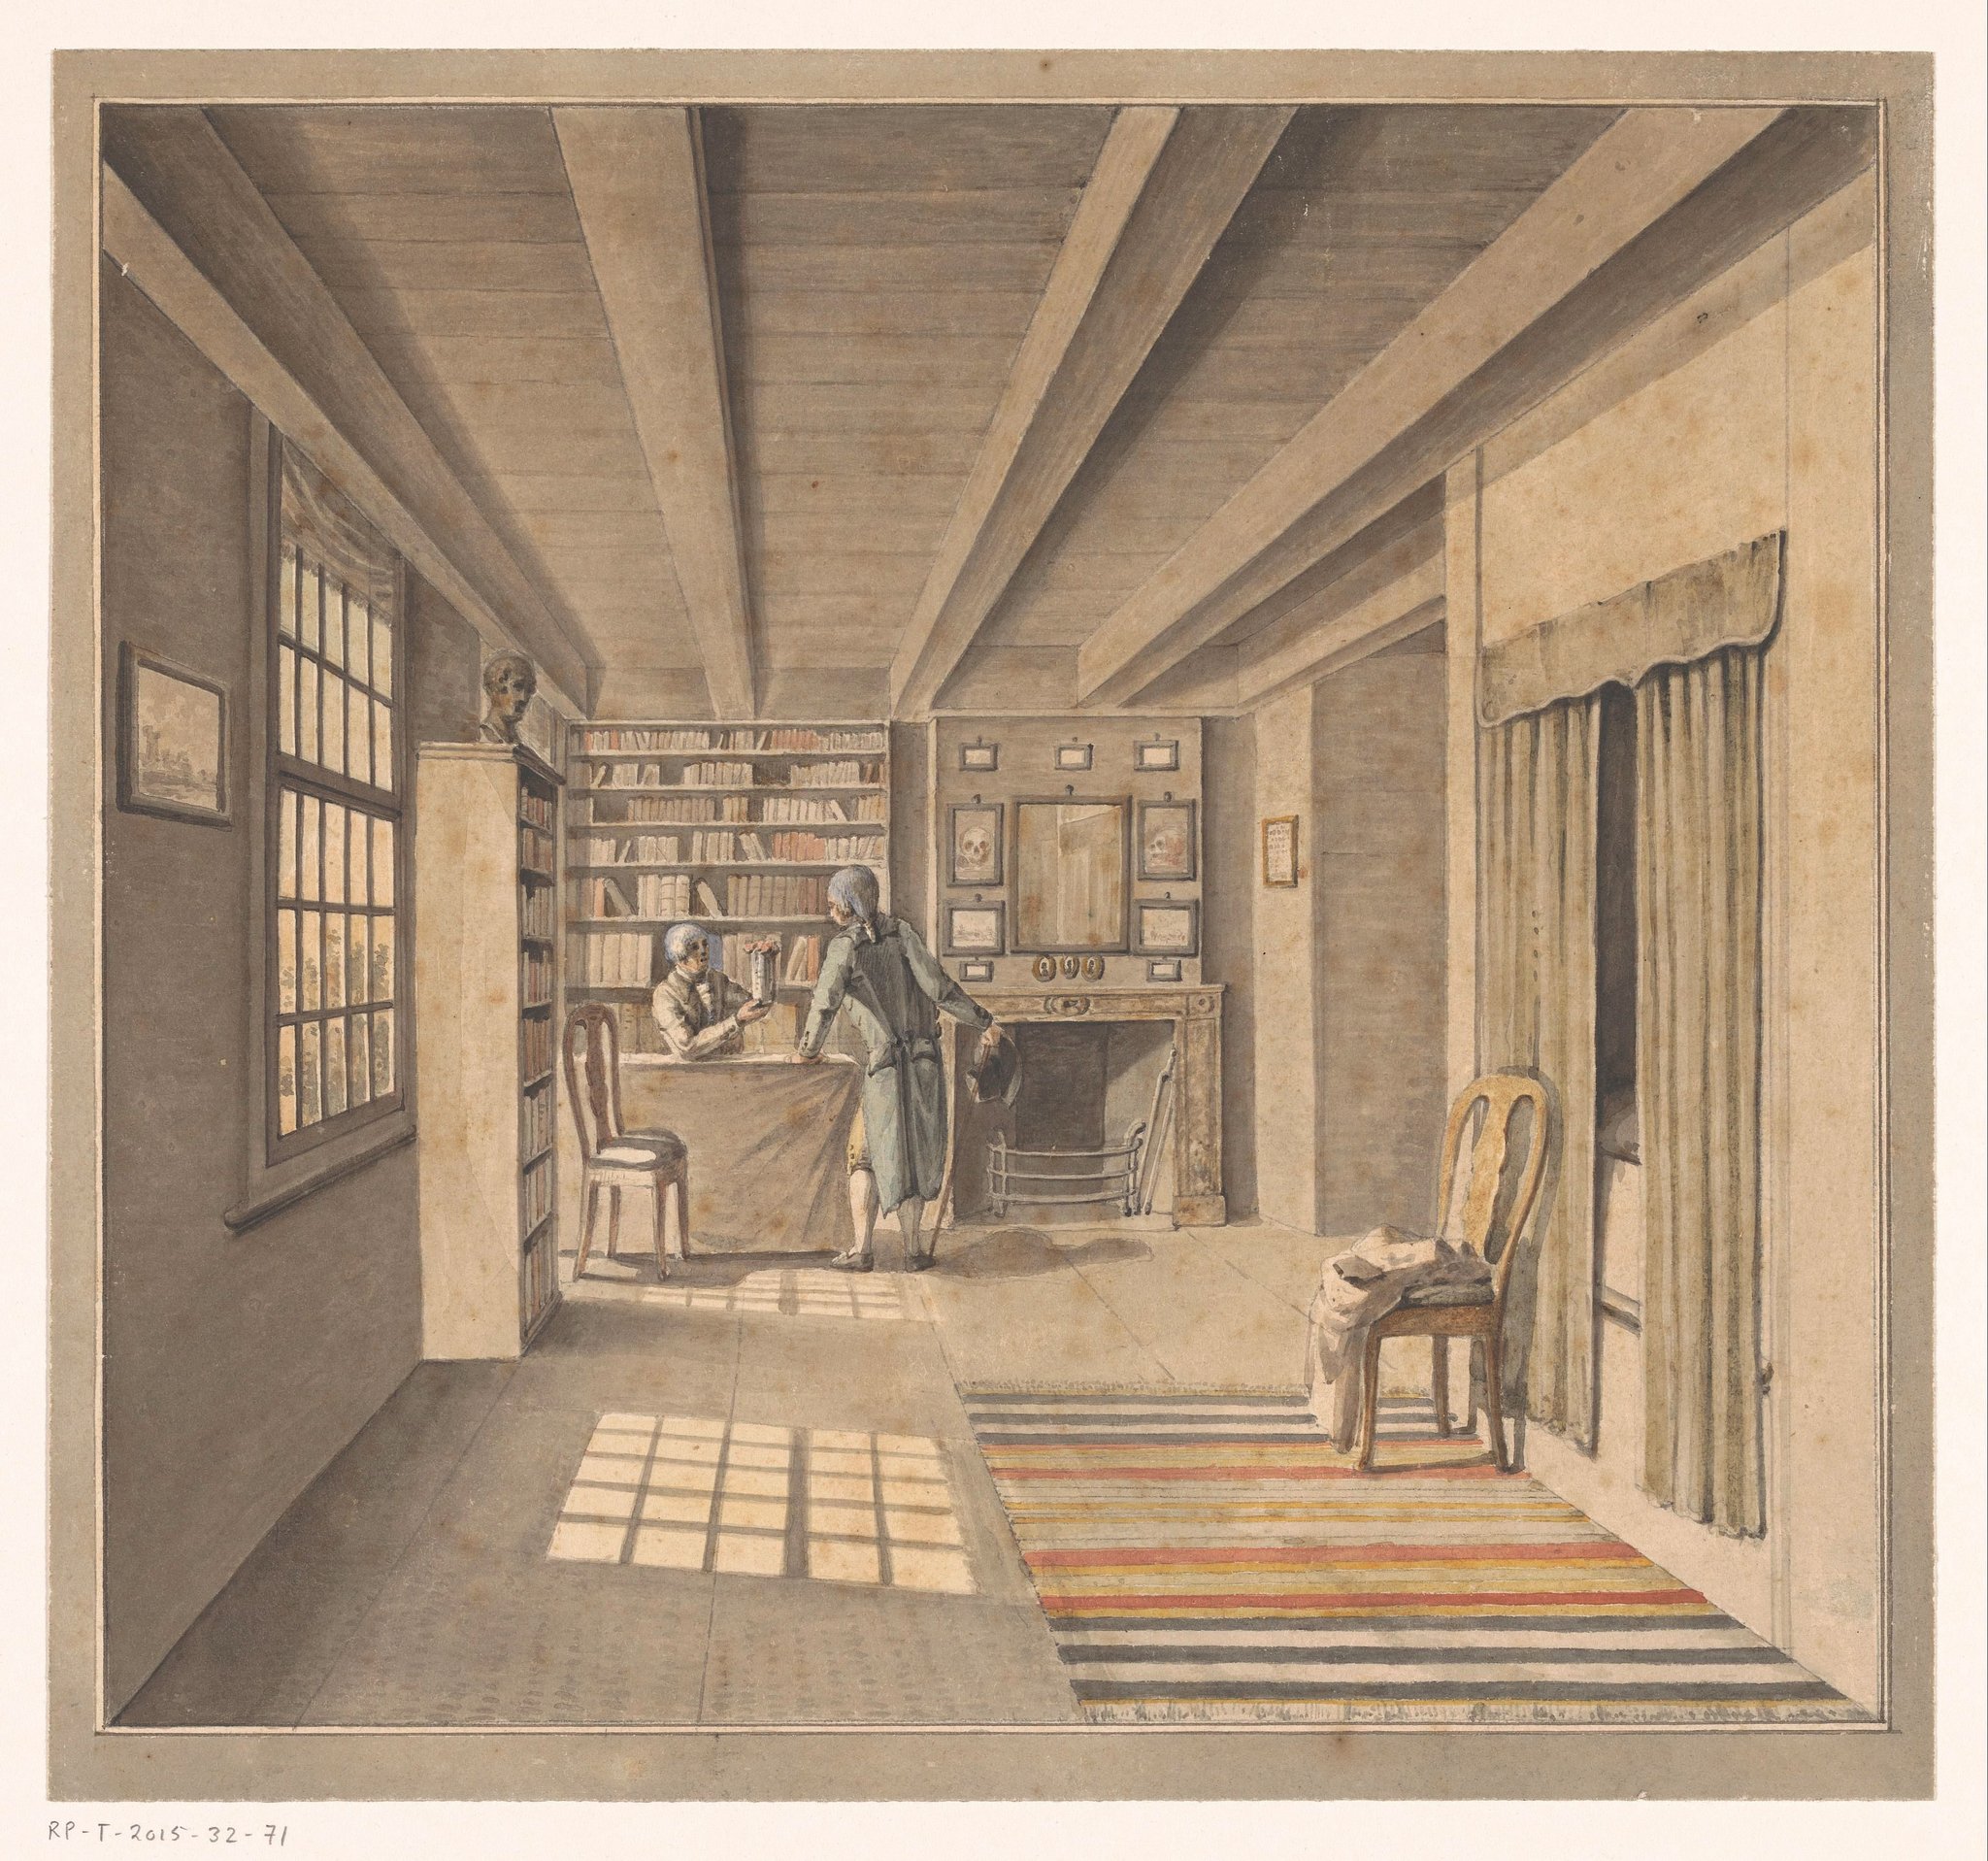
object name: drawing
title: Interieur met een boekverkoper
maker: Anonymous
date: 1800-1850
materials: paper, watercolor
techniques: brush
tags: carpet, rug, print, e.g.: engraving, etching, lithograph, chimney-piece, mantelpiece, built-in bedstead (dutch: 'bedstee'), book-shop, bookseller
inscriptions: watermark, collector's mark: Lugt 2228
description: In de hoek van een kamer zit een boekverkoper achter een tafel voor een boekenkast. Hij laat een boek zien aan een man met een stok en een hoed in zijn rechterhand. Naast de boekenkast een schouw met daarboven een spiegel en enkele ingelijste prenten of tekeningen, waaronder twee doodshoofden. Op de voorgrond een kleed en een stoel voor een bedstee.